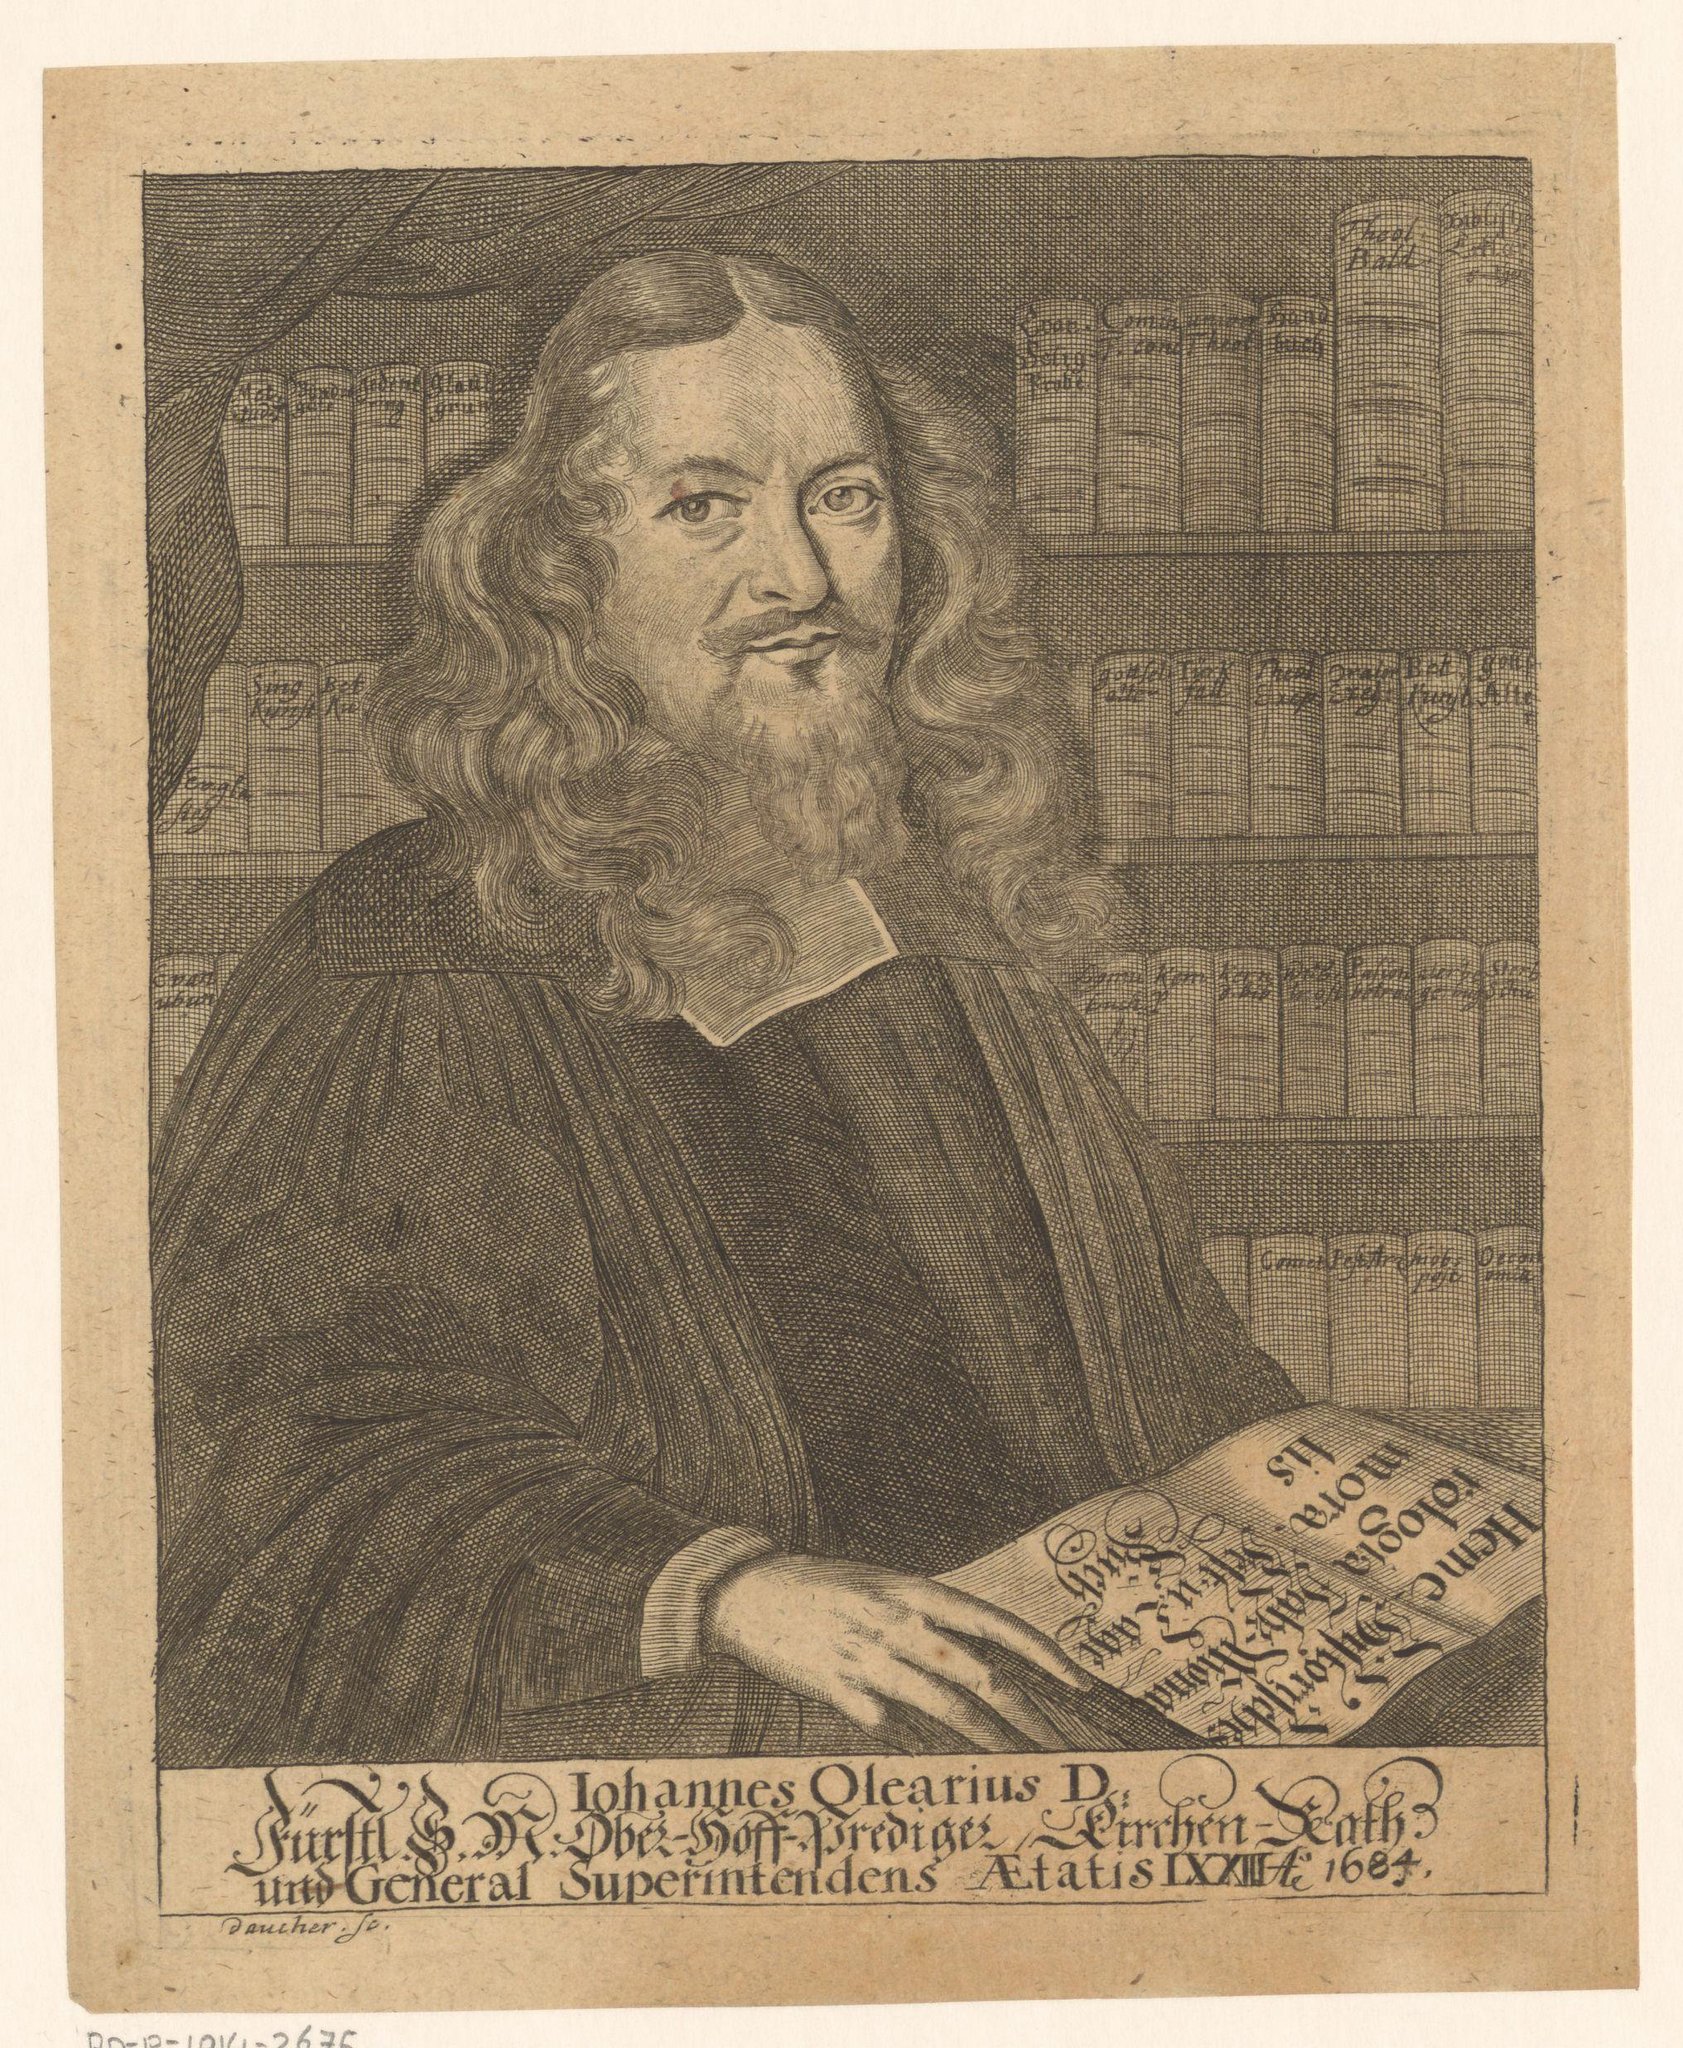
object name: print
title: Portret van Johannes Olearius op 73-jarige leeftijd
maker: daucher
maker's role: print maker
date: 1684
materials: paper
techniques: engraving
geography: germany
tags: johannes olearius, bookshelves, historical persons, book - mm - book open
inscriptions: collector's mark: Lugt 2228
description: De boeken op de achtergrond zijn op de rug voorzien van titels.